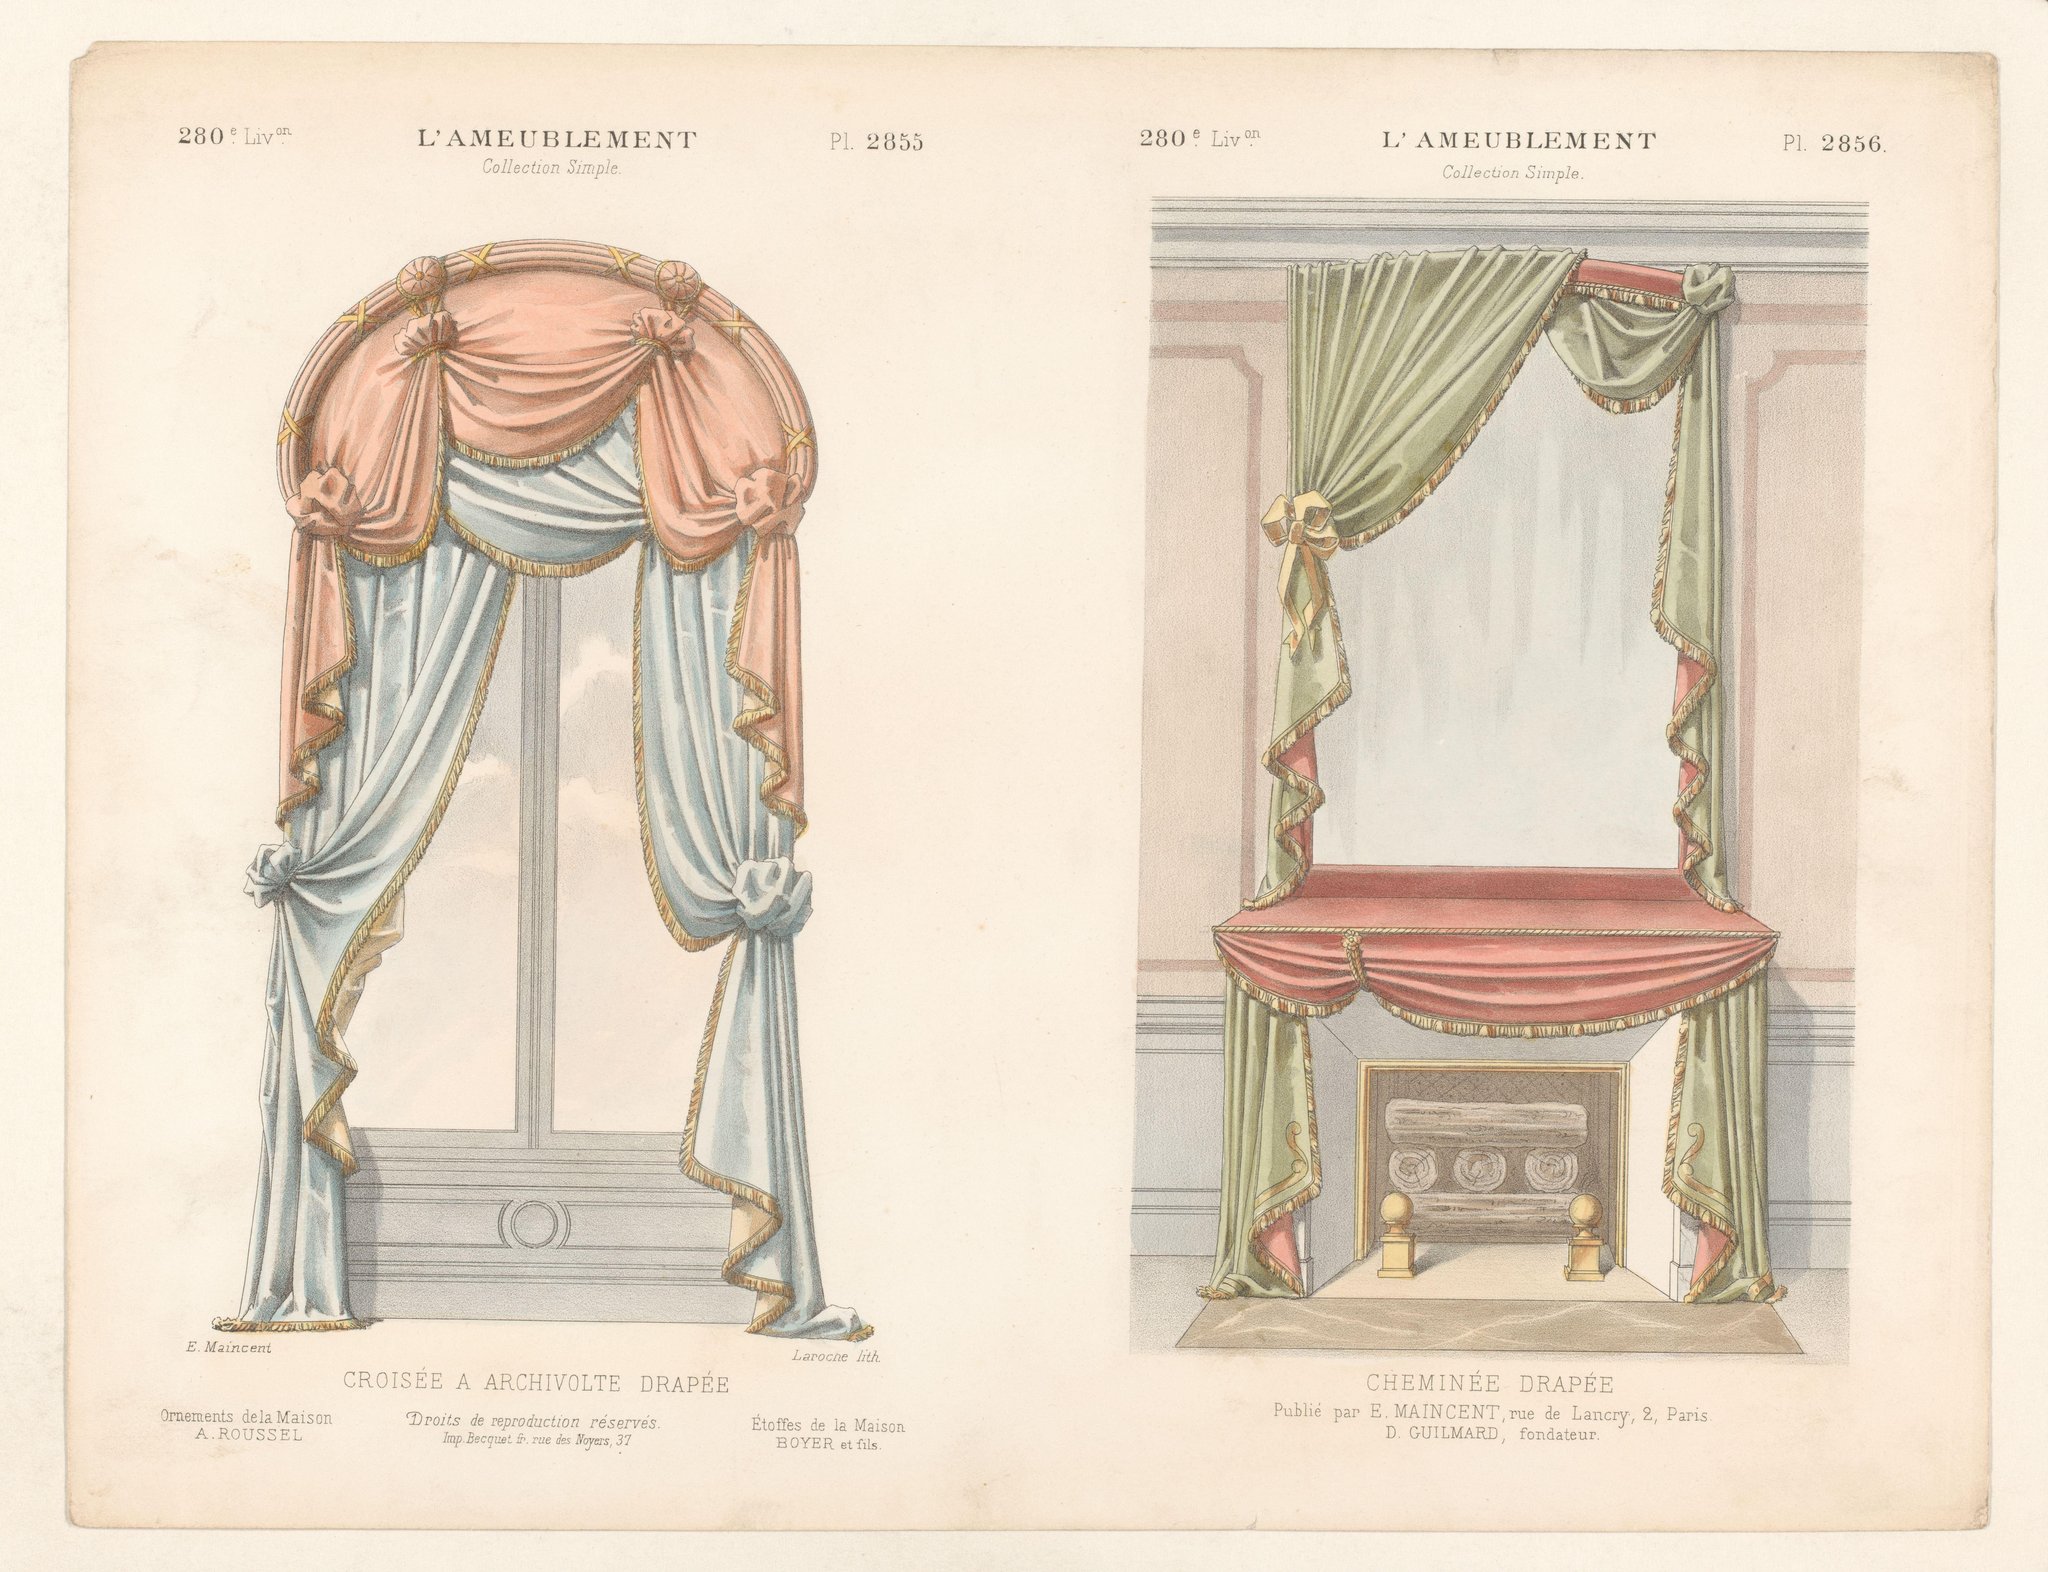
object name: print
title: Croisée à archivolte drapée / Cheminée drapée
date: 1885-1895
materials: paper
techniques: hand coloring, lithograph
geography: paris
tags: curtains, window, open hearth, fire-place, hangings and drapery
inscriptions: : ‘Droits de reproduction réservés.’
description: Kruisvenster met kroonboog en gedrapeerde gordijnen (2855) / Haard met spiegel en draperieën (2856). Prent uit 280e Livraison.